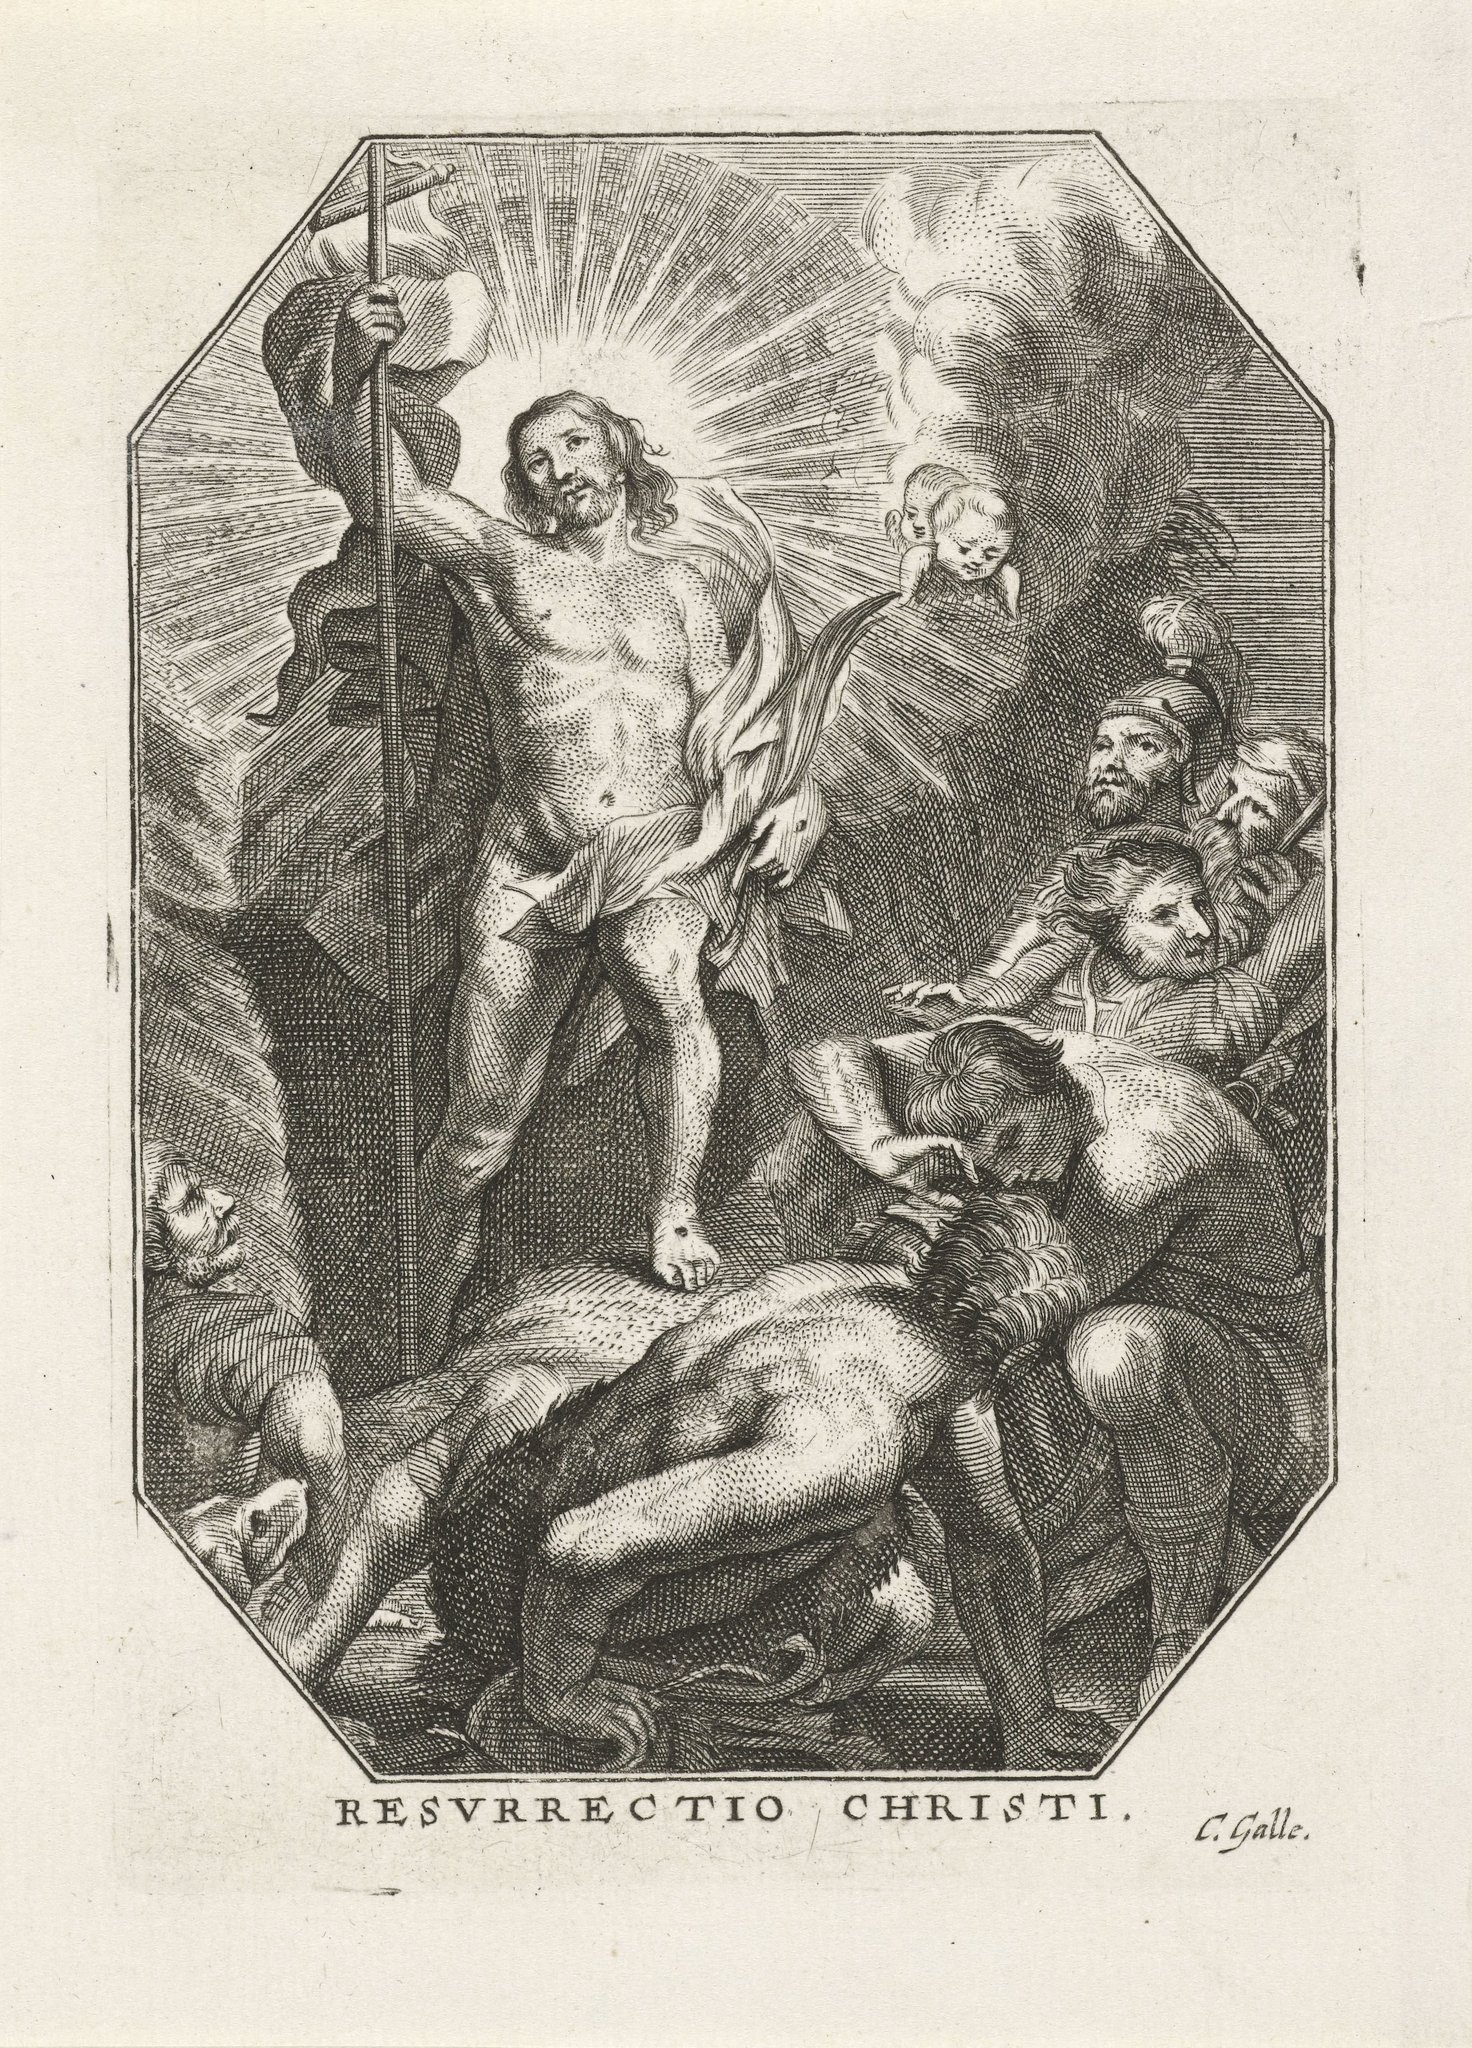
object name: print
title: Resvrectio Christi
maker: cornelis galle (i)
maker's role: print maker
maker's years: 1576-1650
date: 1586-1650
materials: paper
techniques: engraving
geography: southern netherlands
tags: christ, usually holding a banner, arises from the grave; often combined with sleeping and/or frightened soldiers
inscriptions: collector's mark: Lugt 2228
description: Christus verrijst uit het graf. Hij draagt een palmtak en een kruis met een vaandel in zijn handen. Licht straalt vanaf zijn hoofd. De soldaten die bij het graf de wacht houden deinzen terug voor het licht. Laatste prent uit een serie van 13, met voorstellingen uit het lijdensverhaal van Christus.